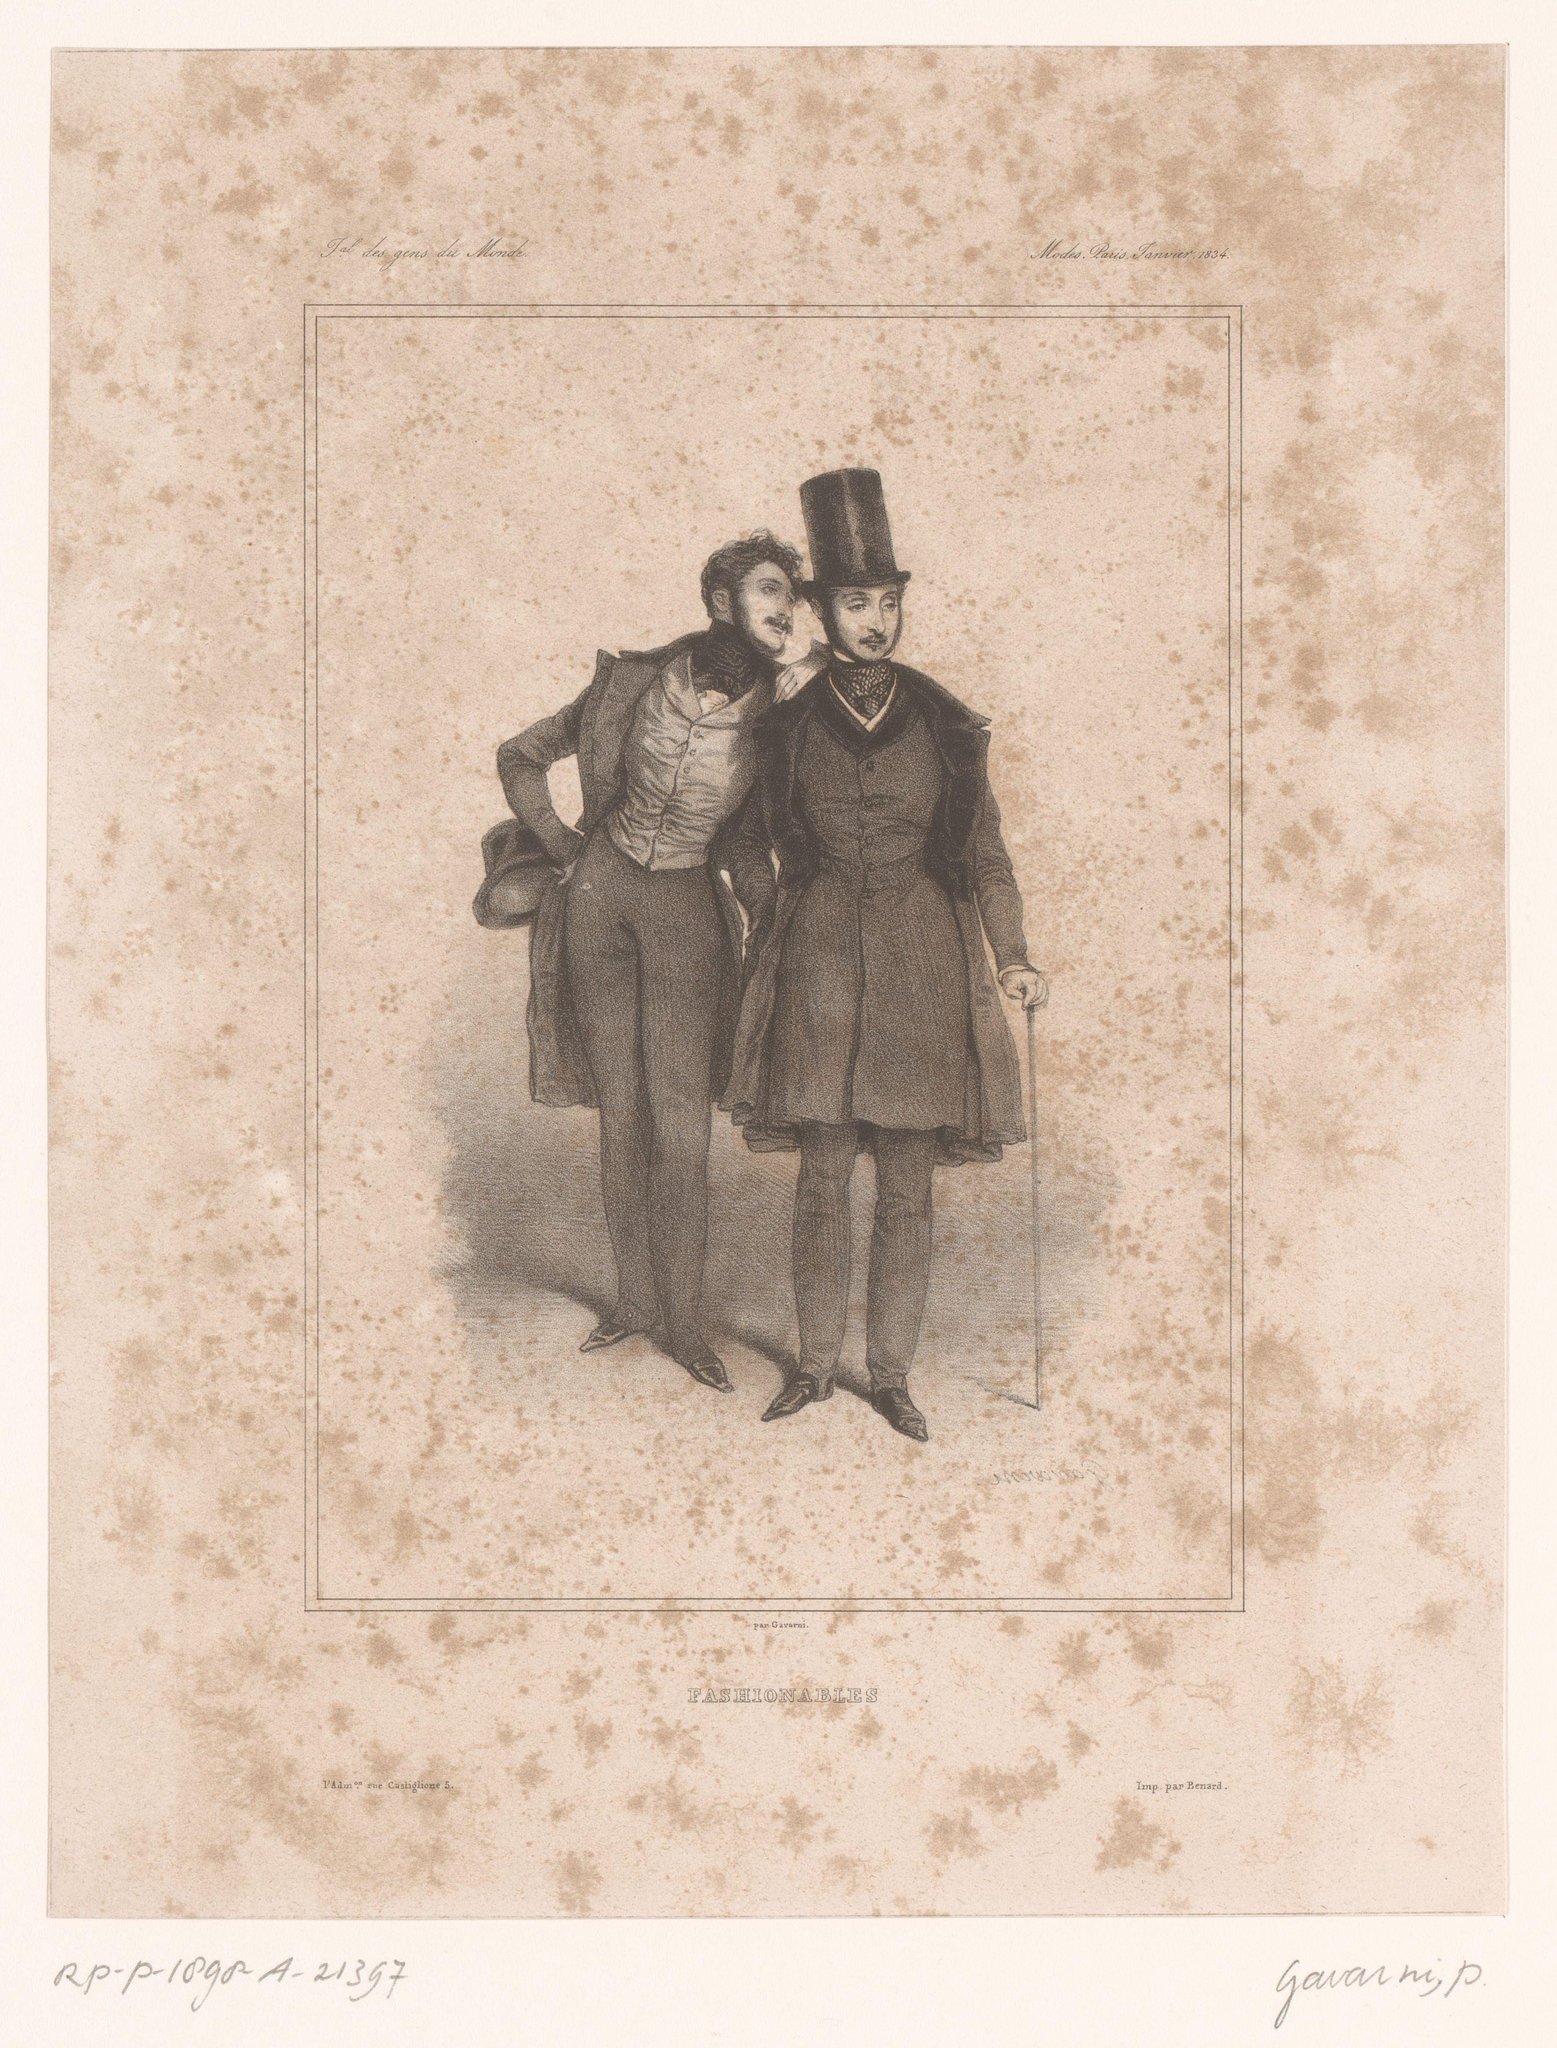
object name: print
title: Twee modieuze mannen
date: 1834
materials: paper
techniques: lithograph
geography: paris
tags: dandy, beau, fashion plates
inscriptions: collector's mark: Lugt 964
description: Prent gebruikt voor: Journal du Gens du Monde, januari 1834.